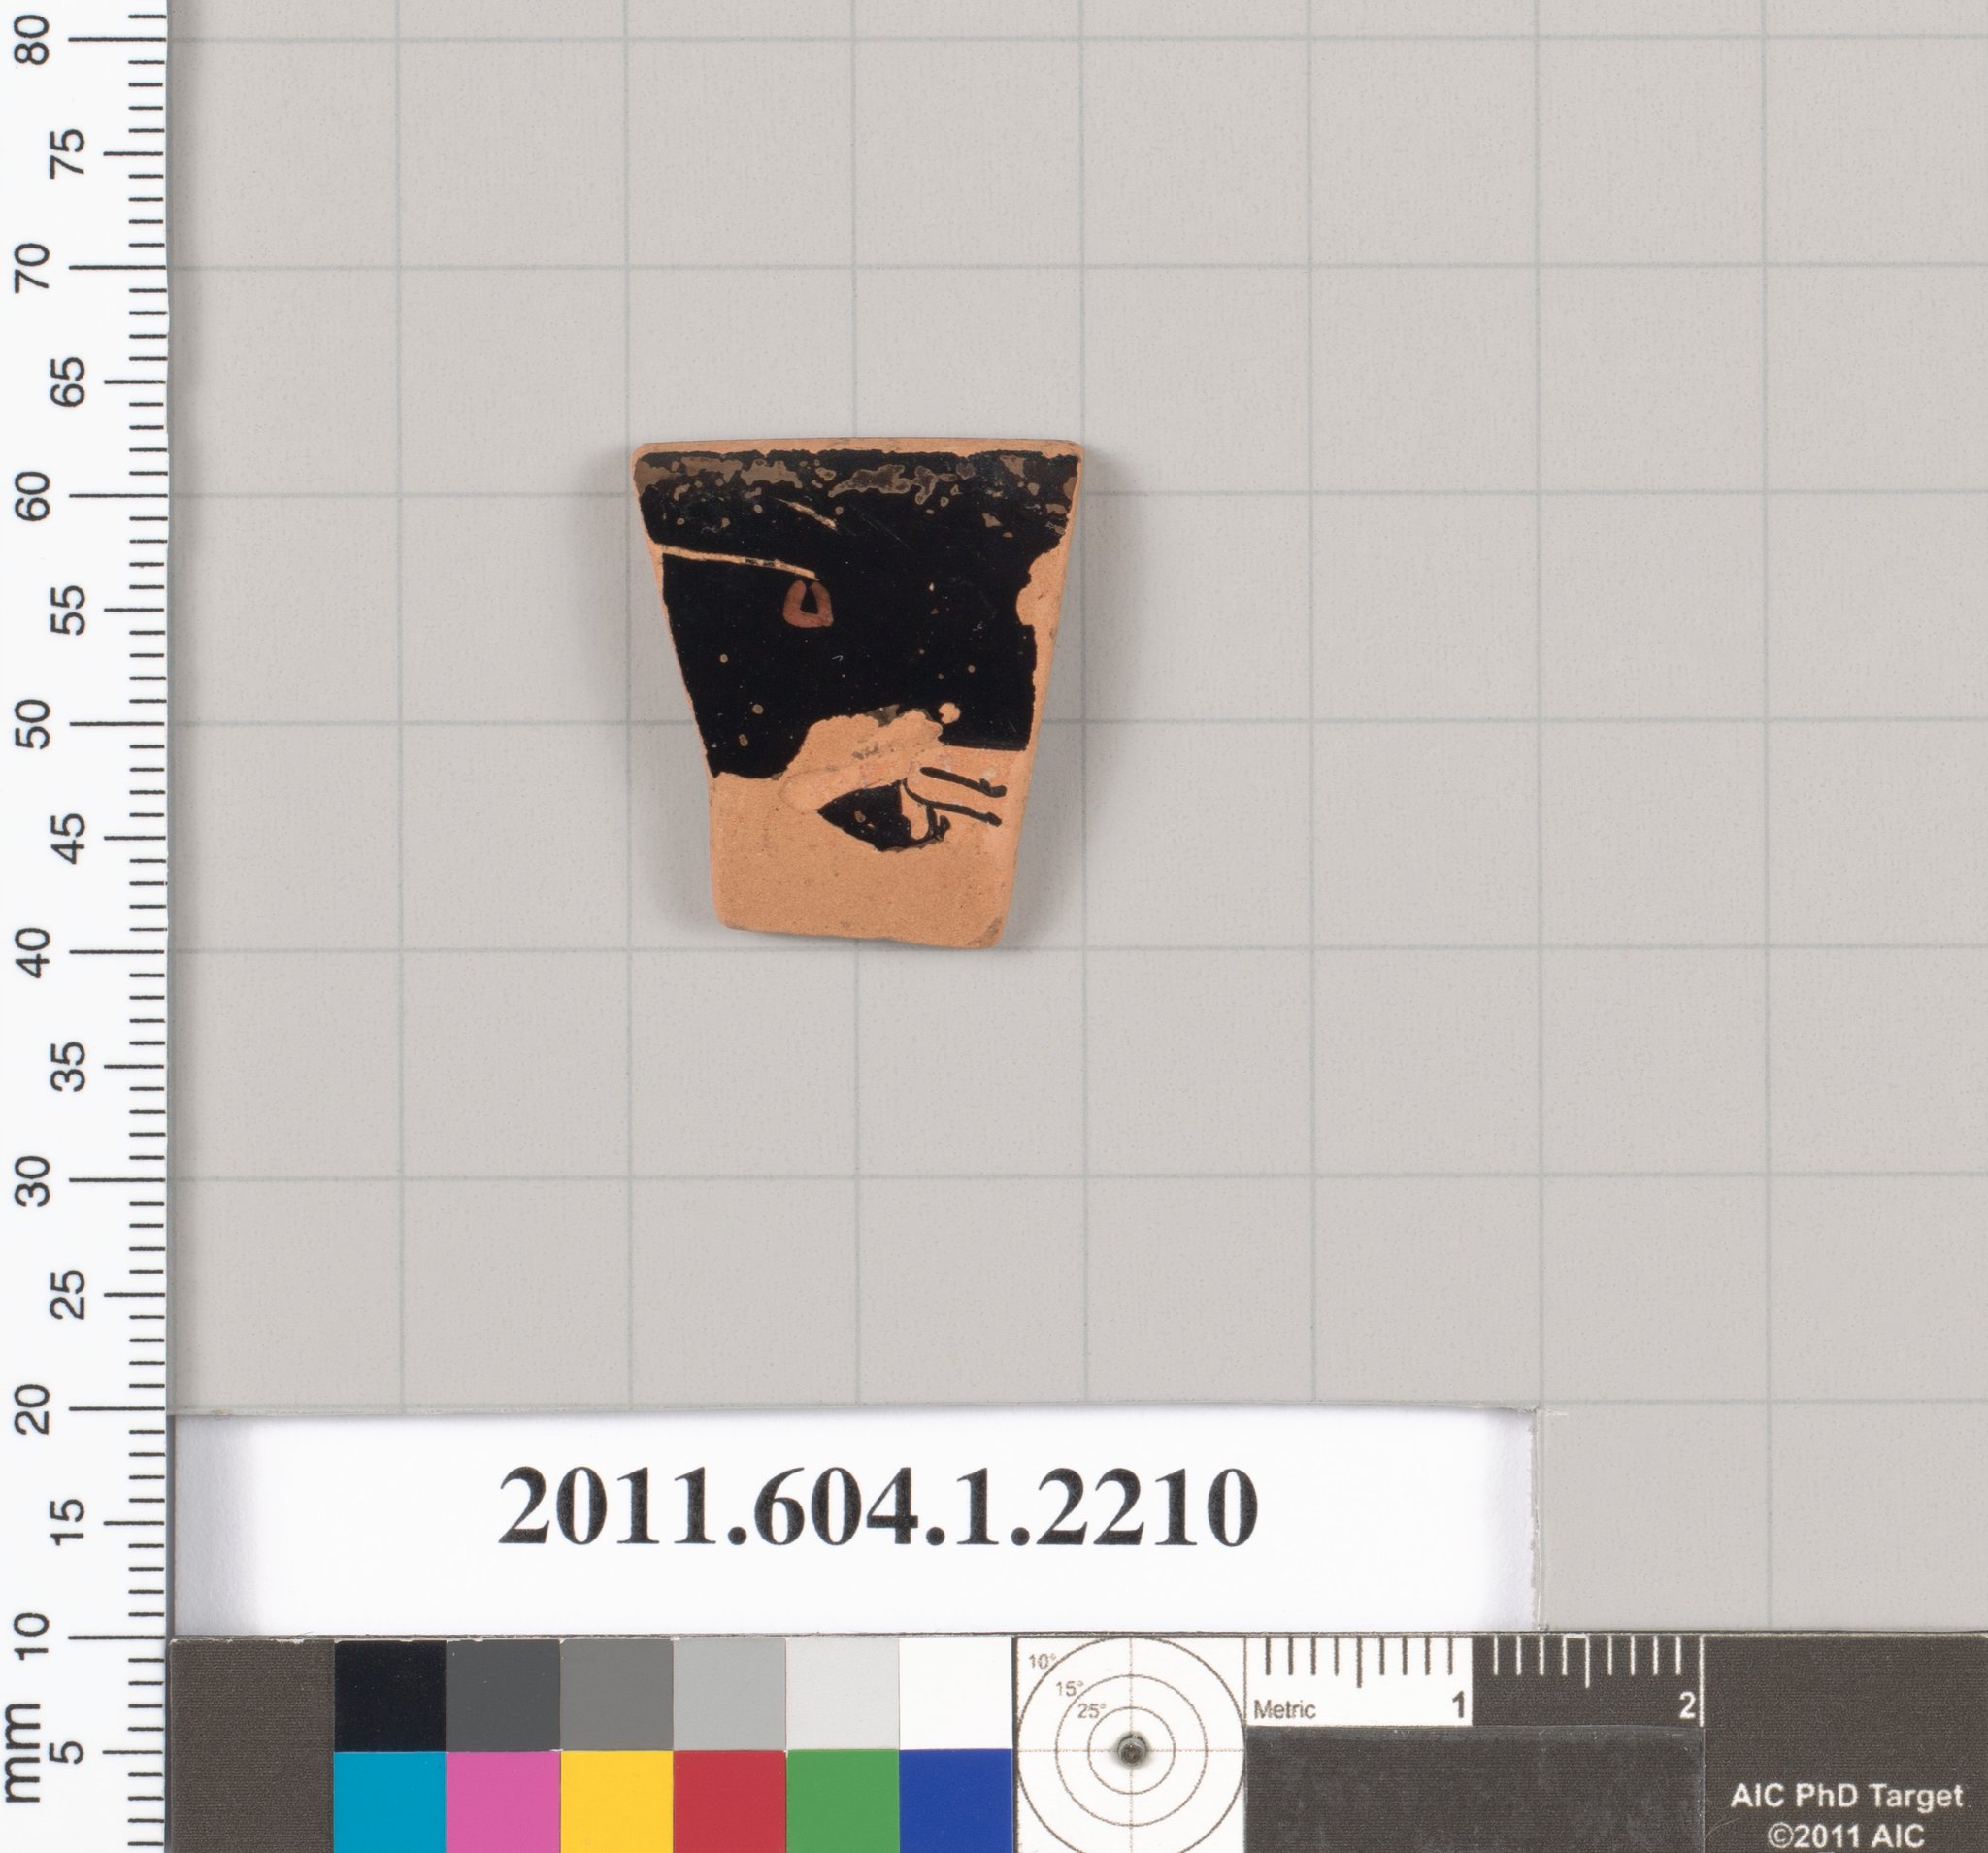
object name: kylix fragment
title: Terracotta rim fragment of a kylix (drinking cup)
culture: greek, attic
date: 500-451 BCE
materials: terracotta